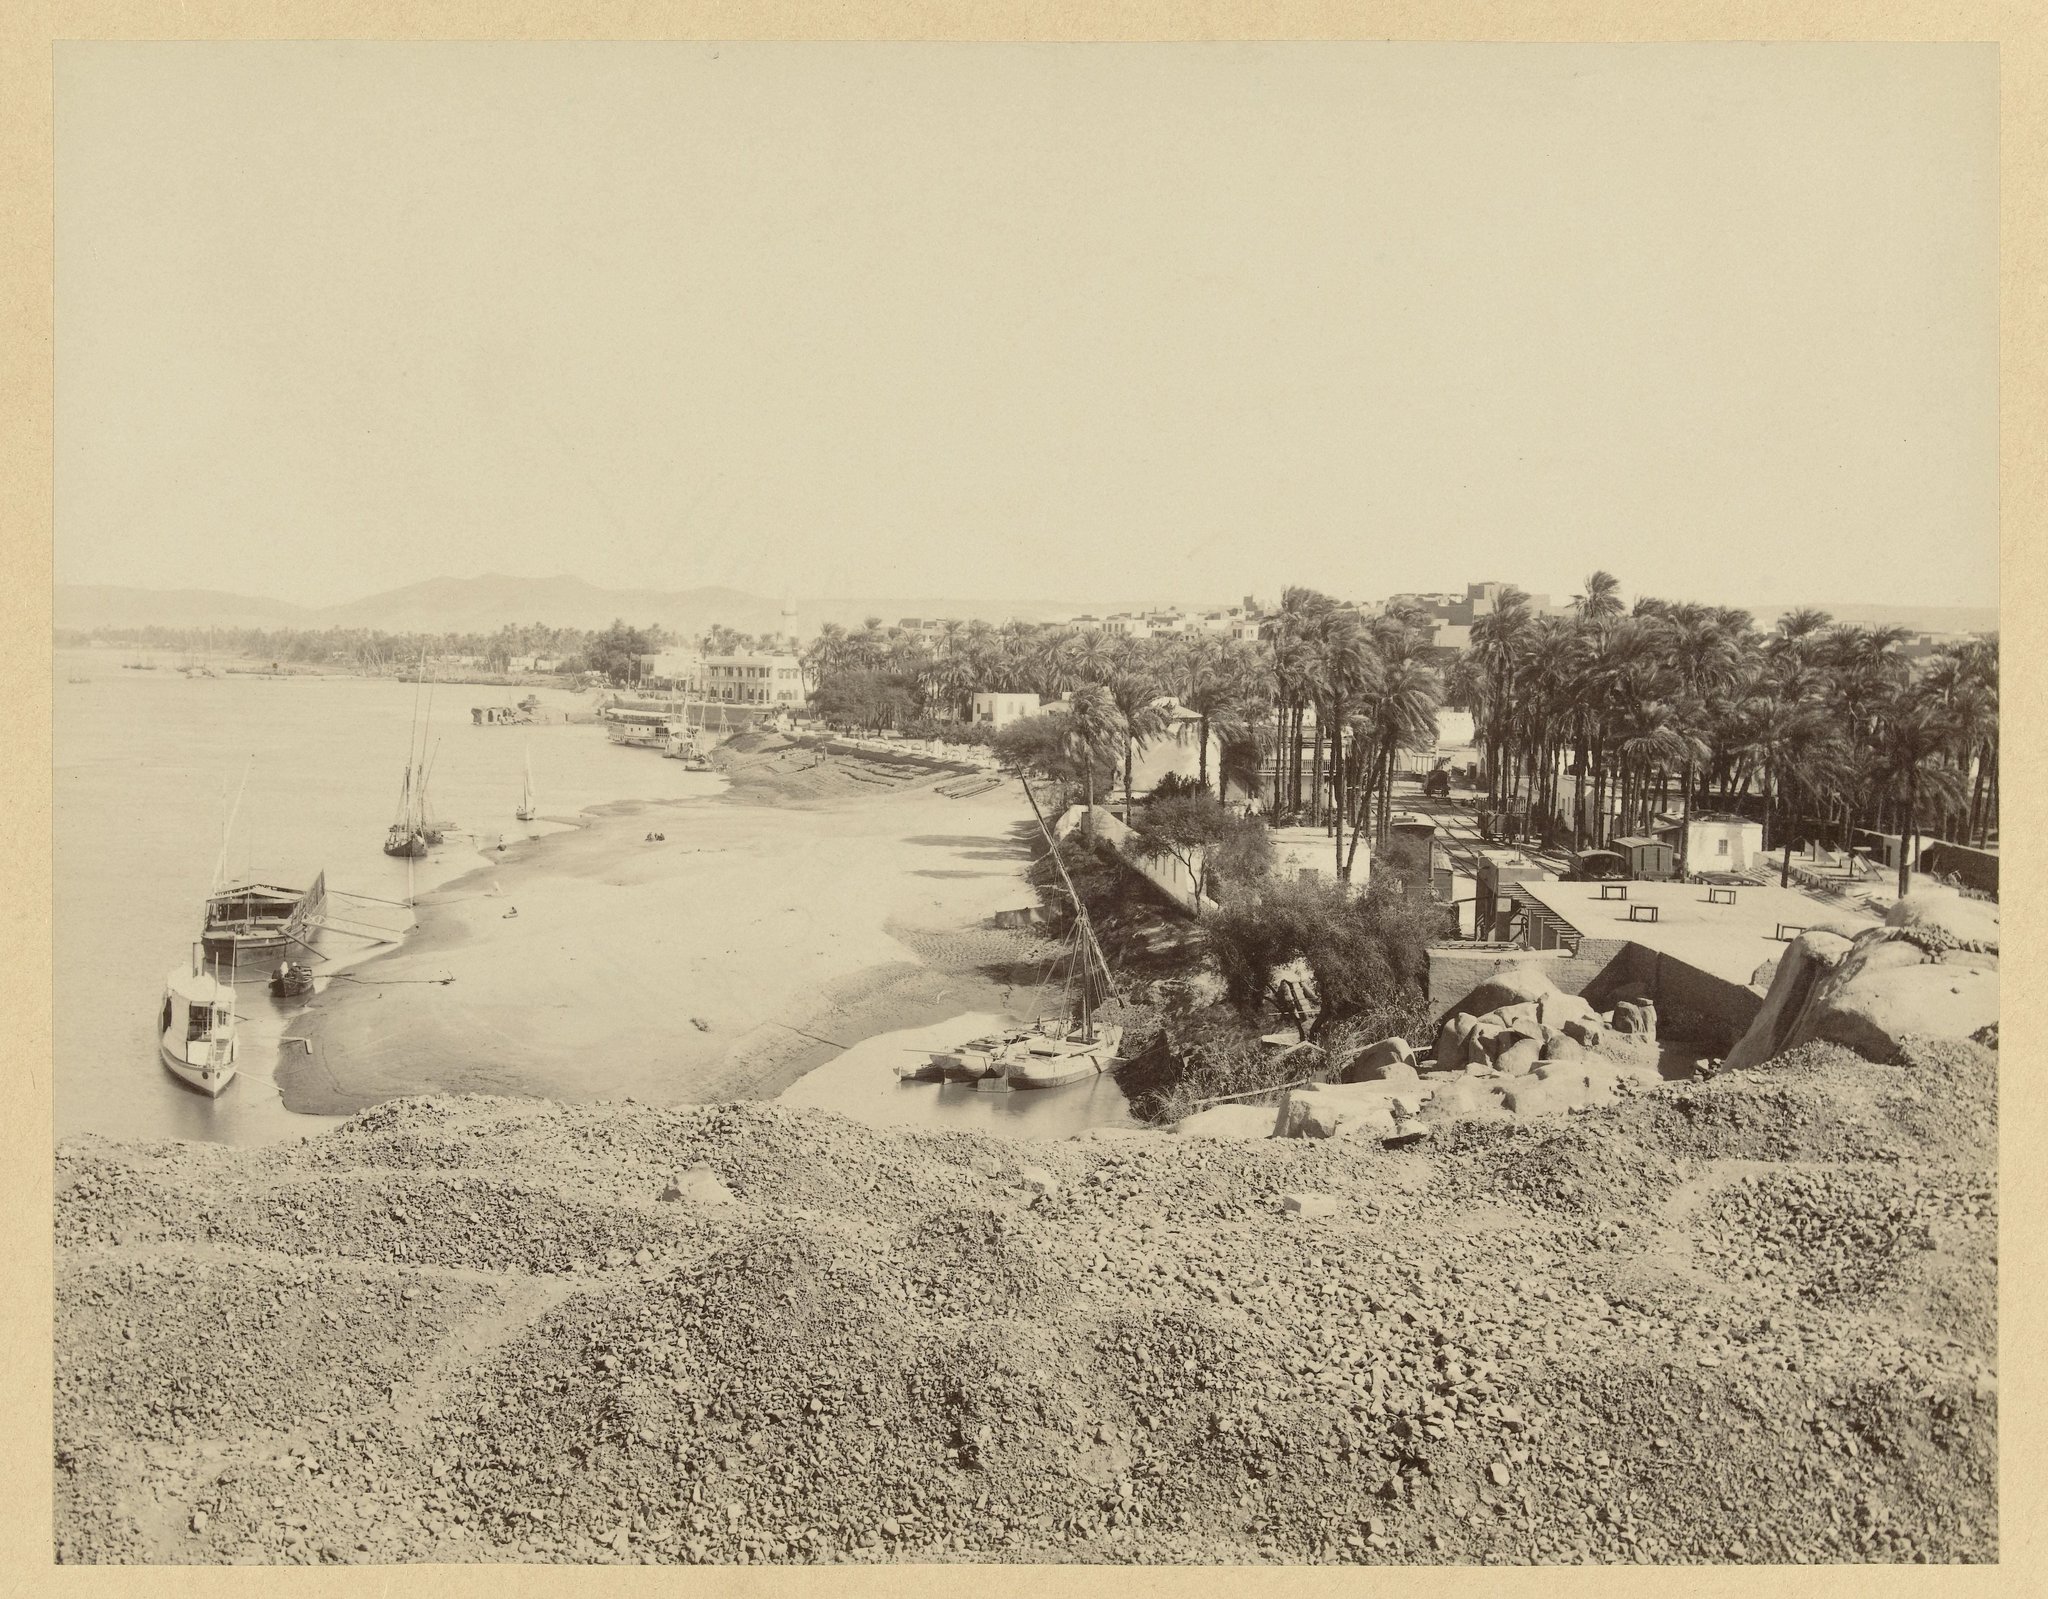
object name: photograph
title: Zicht op Aswan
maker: Anonymous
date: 1890-1895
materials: cardboard, paper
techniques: albumen print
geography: aswan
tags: harbour, river, prospect of city, town panorama, silhouette of city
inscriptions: title: ‘E 94. Assouan (583 mijlen van Caïro). Opper-Egypte’, check stamp: ‘Bristol/ L.M’, stamp: ‘GEMEENTELIJKE BIBLIOTHEEK/ ROTTERDAM’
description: Onderdeel van een groep door fotograaf Richard Polak op reis verzamelde foto’s. Deze foto is samen met andere op zijn reizen verzamelde foto's tentoongesteld bij de Rotterdamsche Kunstkring (1895), Arti en Amicitiae te Amsterdam (1897-1898?) en Societeit 't Collegie te Kampen (datum vooralsnog onbekend).